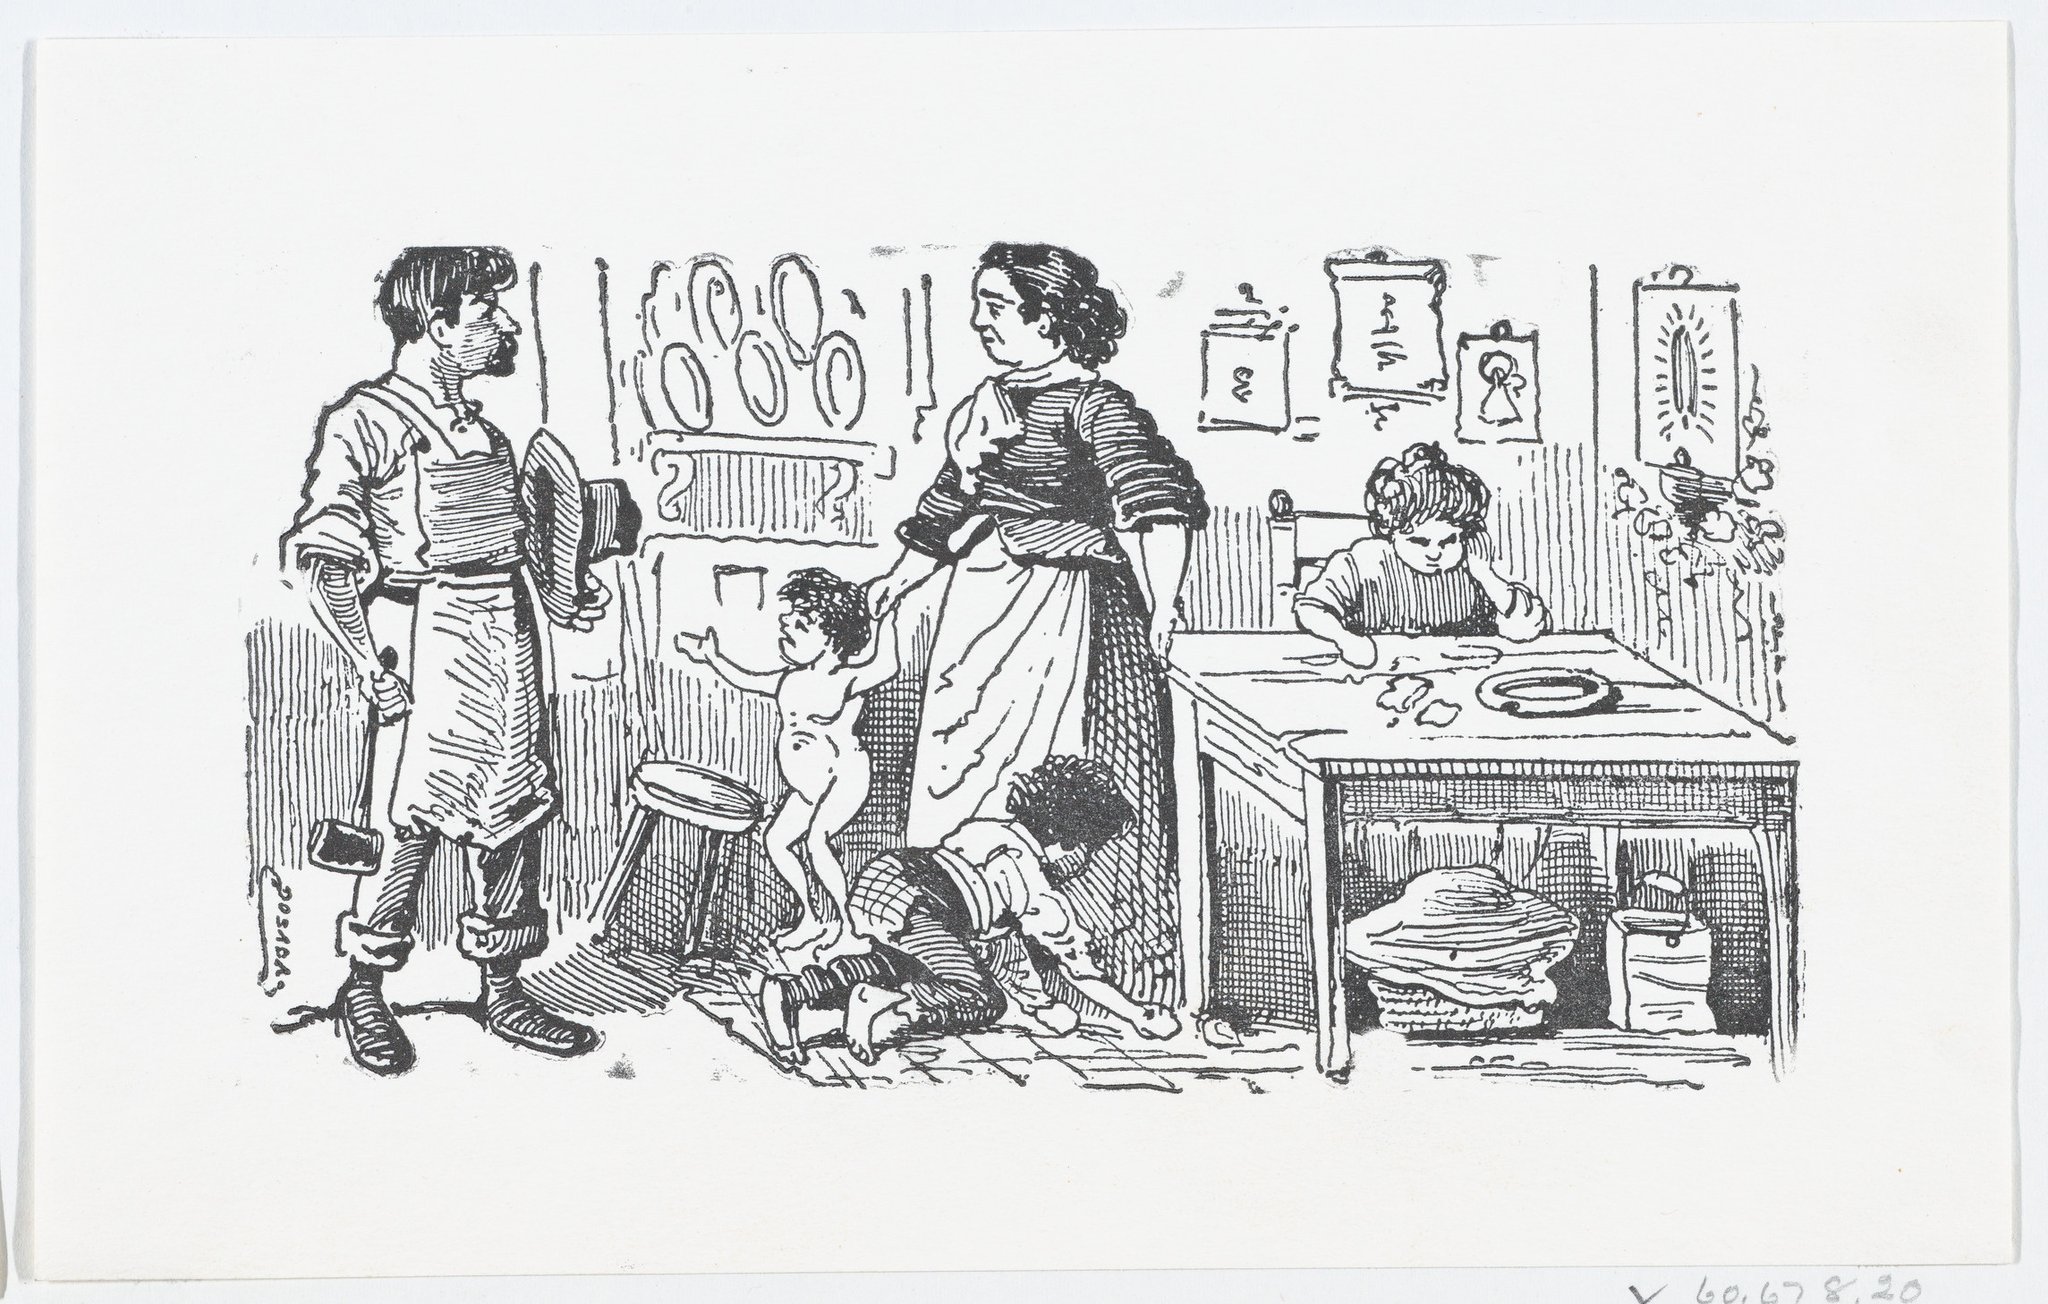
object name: print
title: A domestic scene with a mother holding her child's hand while talking to her husband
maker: josé guadalupe posada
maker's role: artist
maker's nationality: mexican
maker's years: 1852-1913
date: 1880-1910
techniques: lithography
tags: children,men,women,genre scene,family